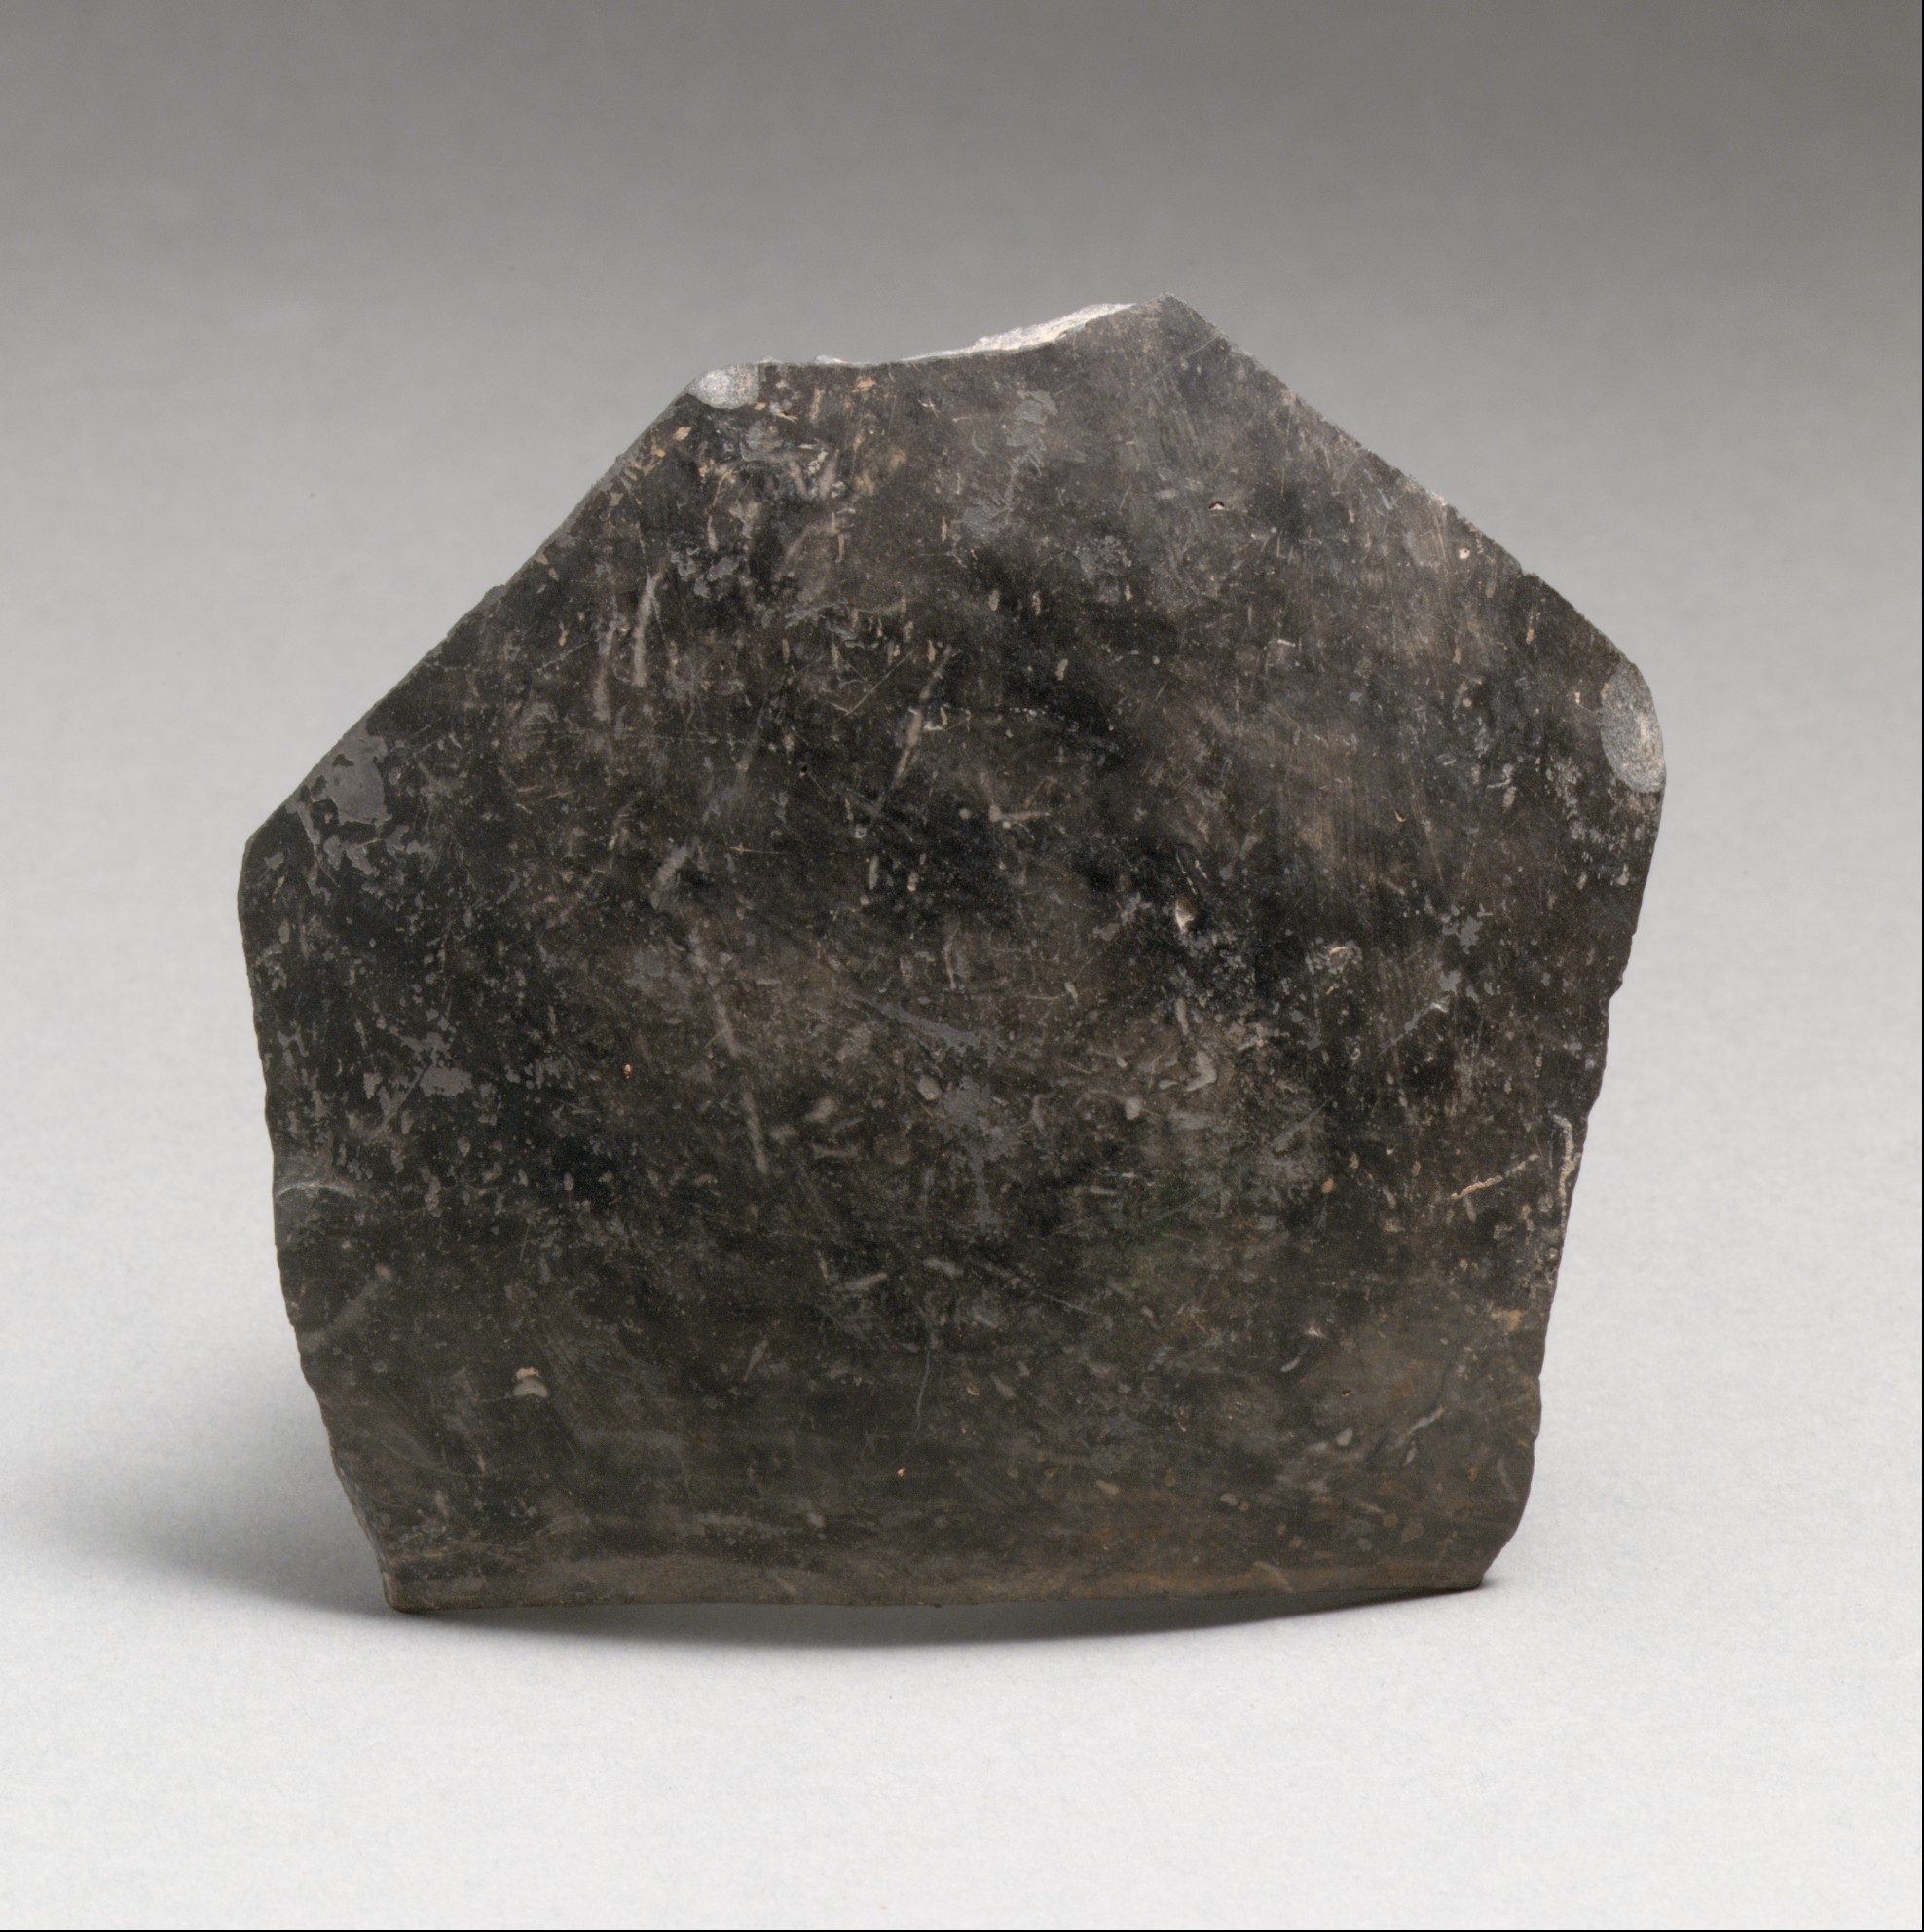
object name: vase fragment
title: Terracotta rim fragment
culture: greek neolithic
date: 4000 BCE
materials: terracotta